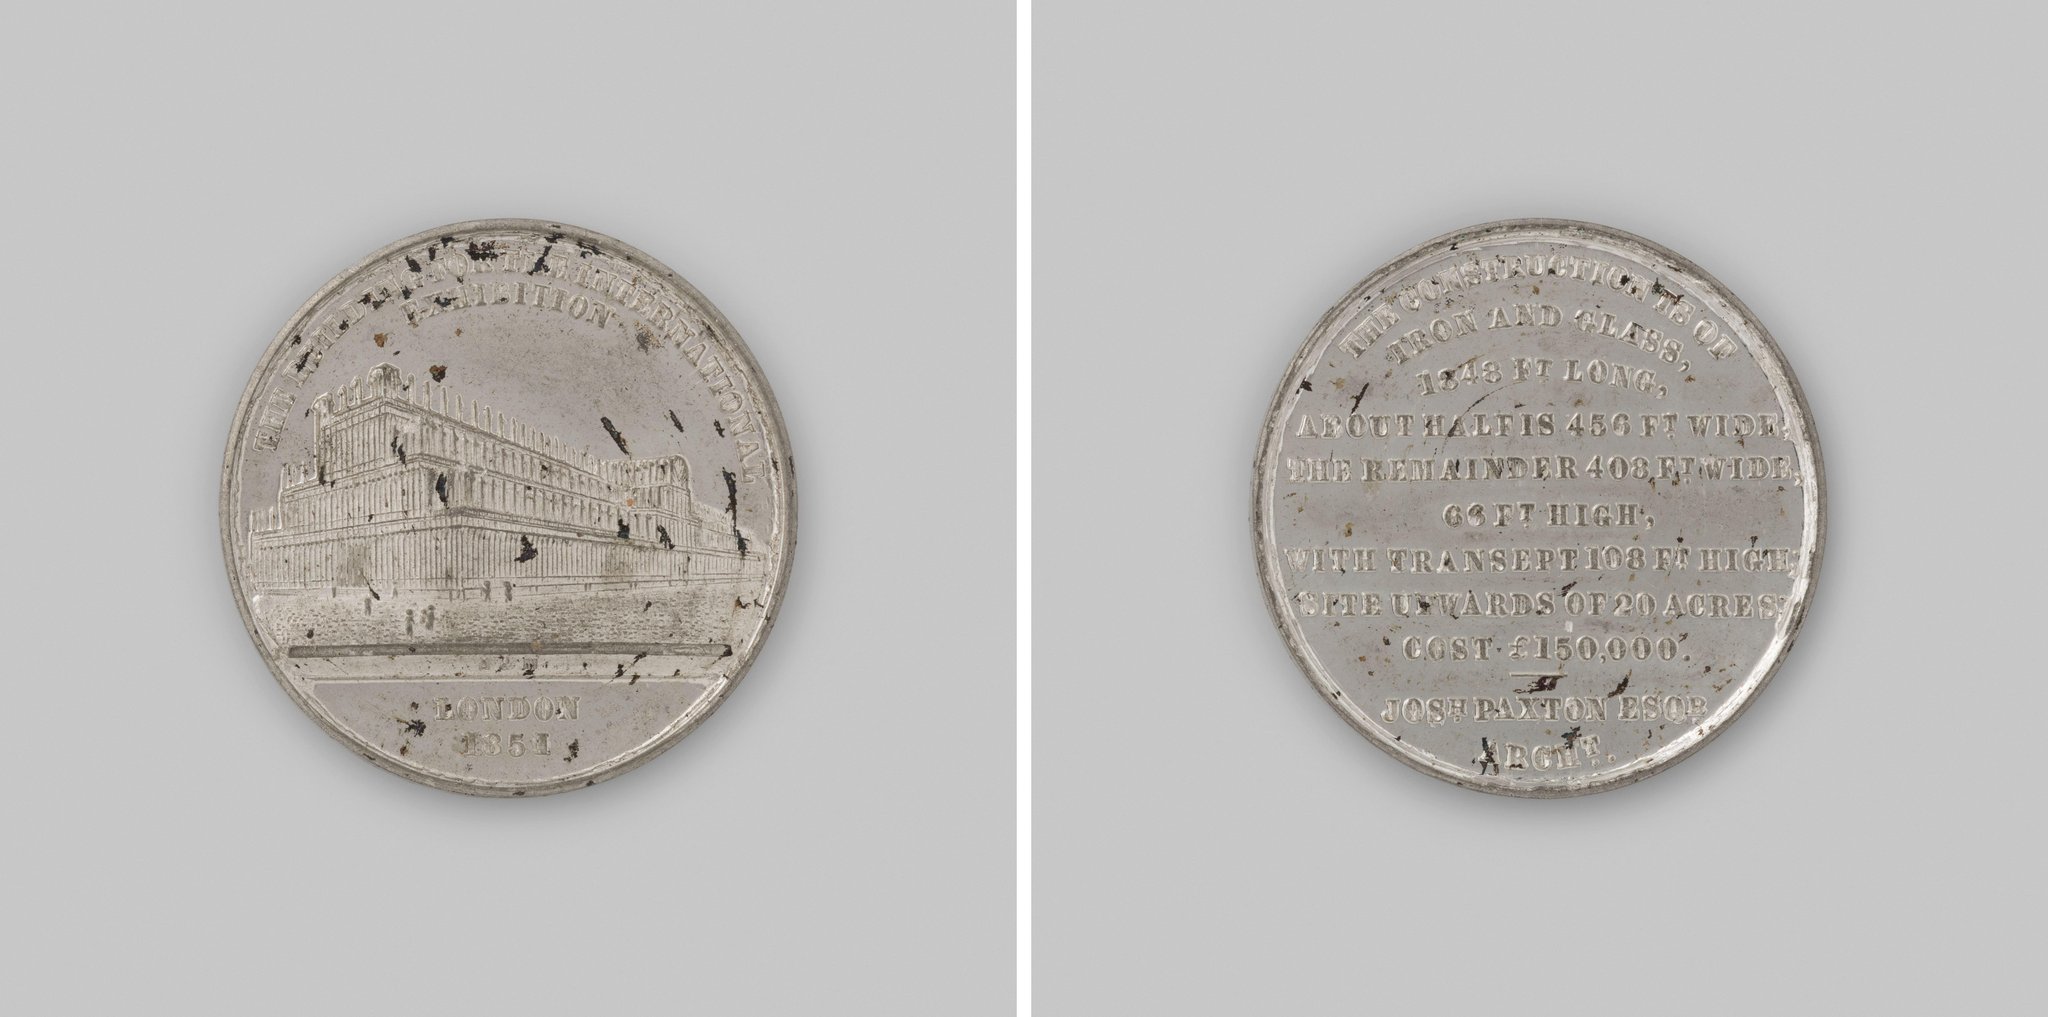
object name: history medal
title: Bouw van het Crystal Palace voor de Internationale tentoonstelling van industrie te Londen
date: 1851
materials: alloy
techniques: striking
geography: birmingham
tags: crystal palace, wereldtentoonstelling 1851 (londen)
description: Penning. Voorzijde: paleis binnen omschrift; afsnede: opschrift. Keerzijde: opschrift binnen omschrift.